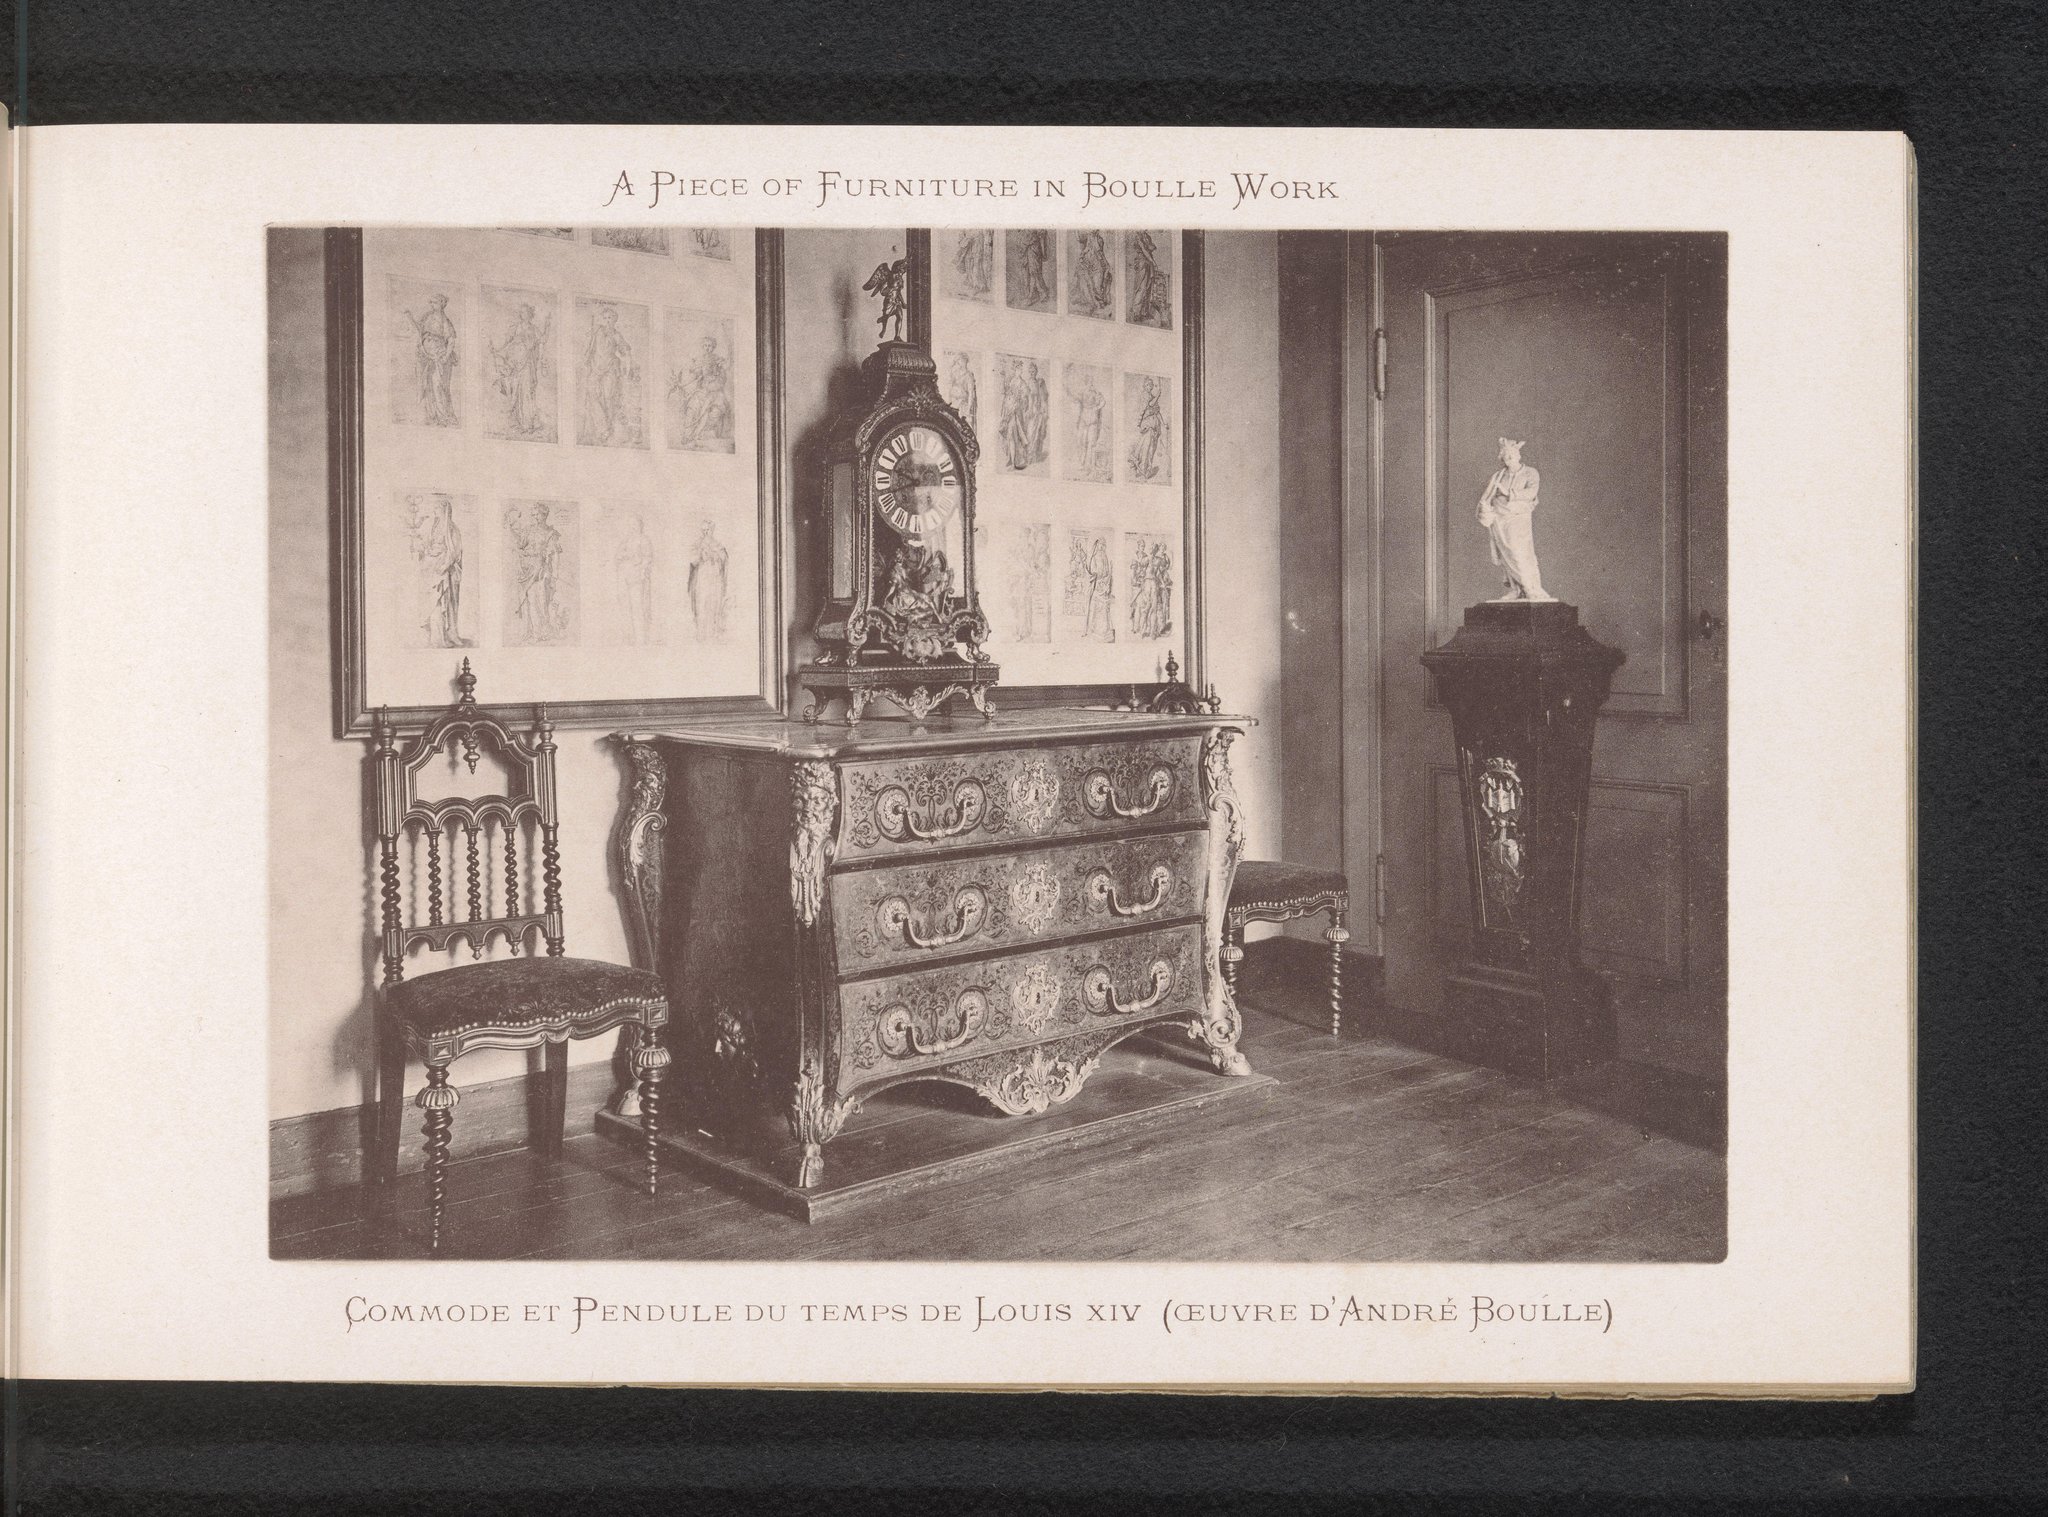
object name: photomechanical print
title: A piece of furniture in Boulle work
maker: Anonymous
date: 1892-1897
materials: paper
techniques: photograph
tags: furniture for storage, clock